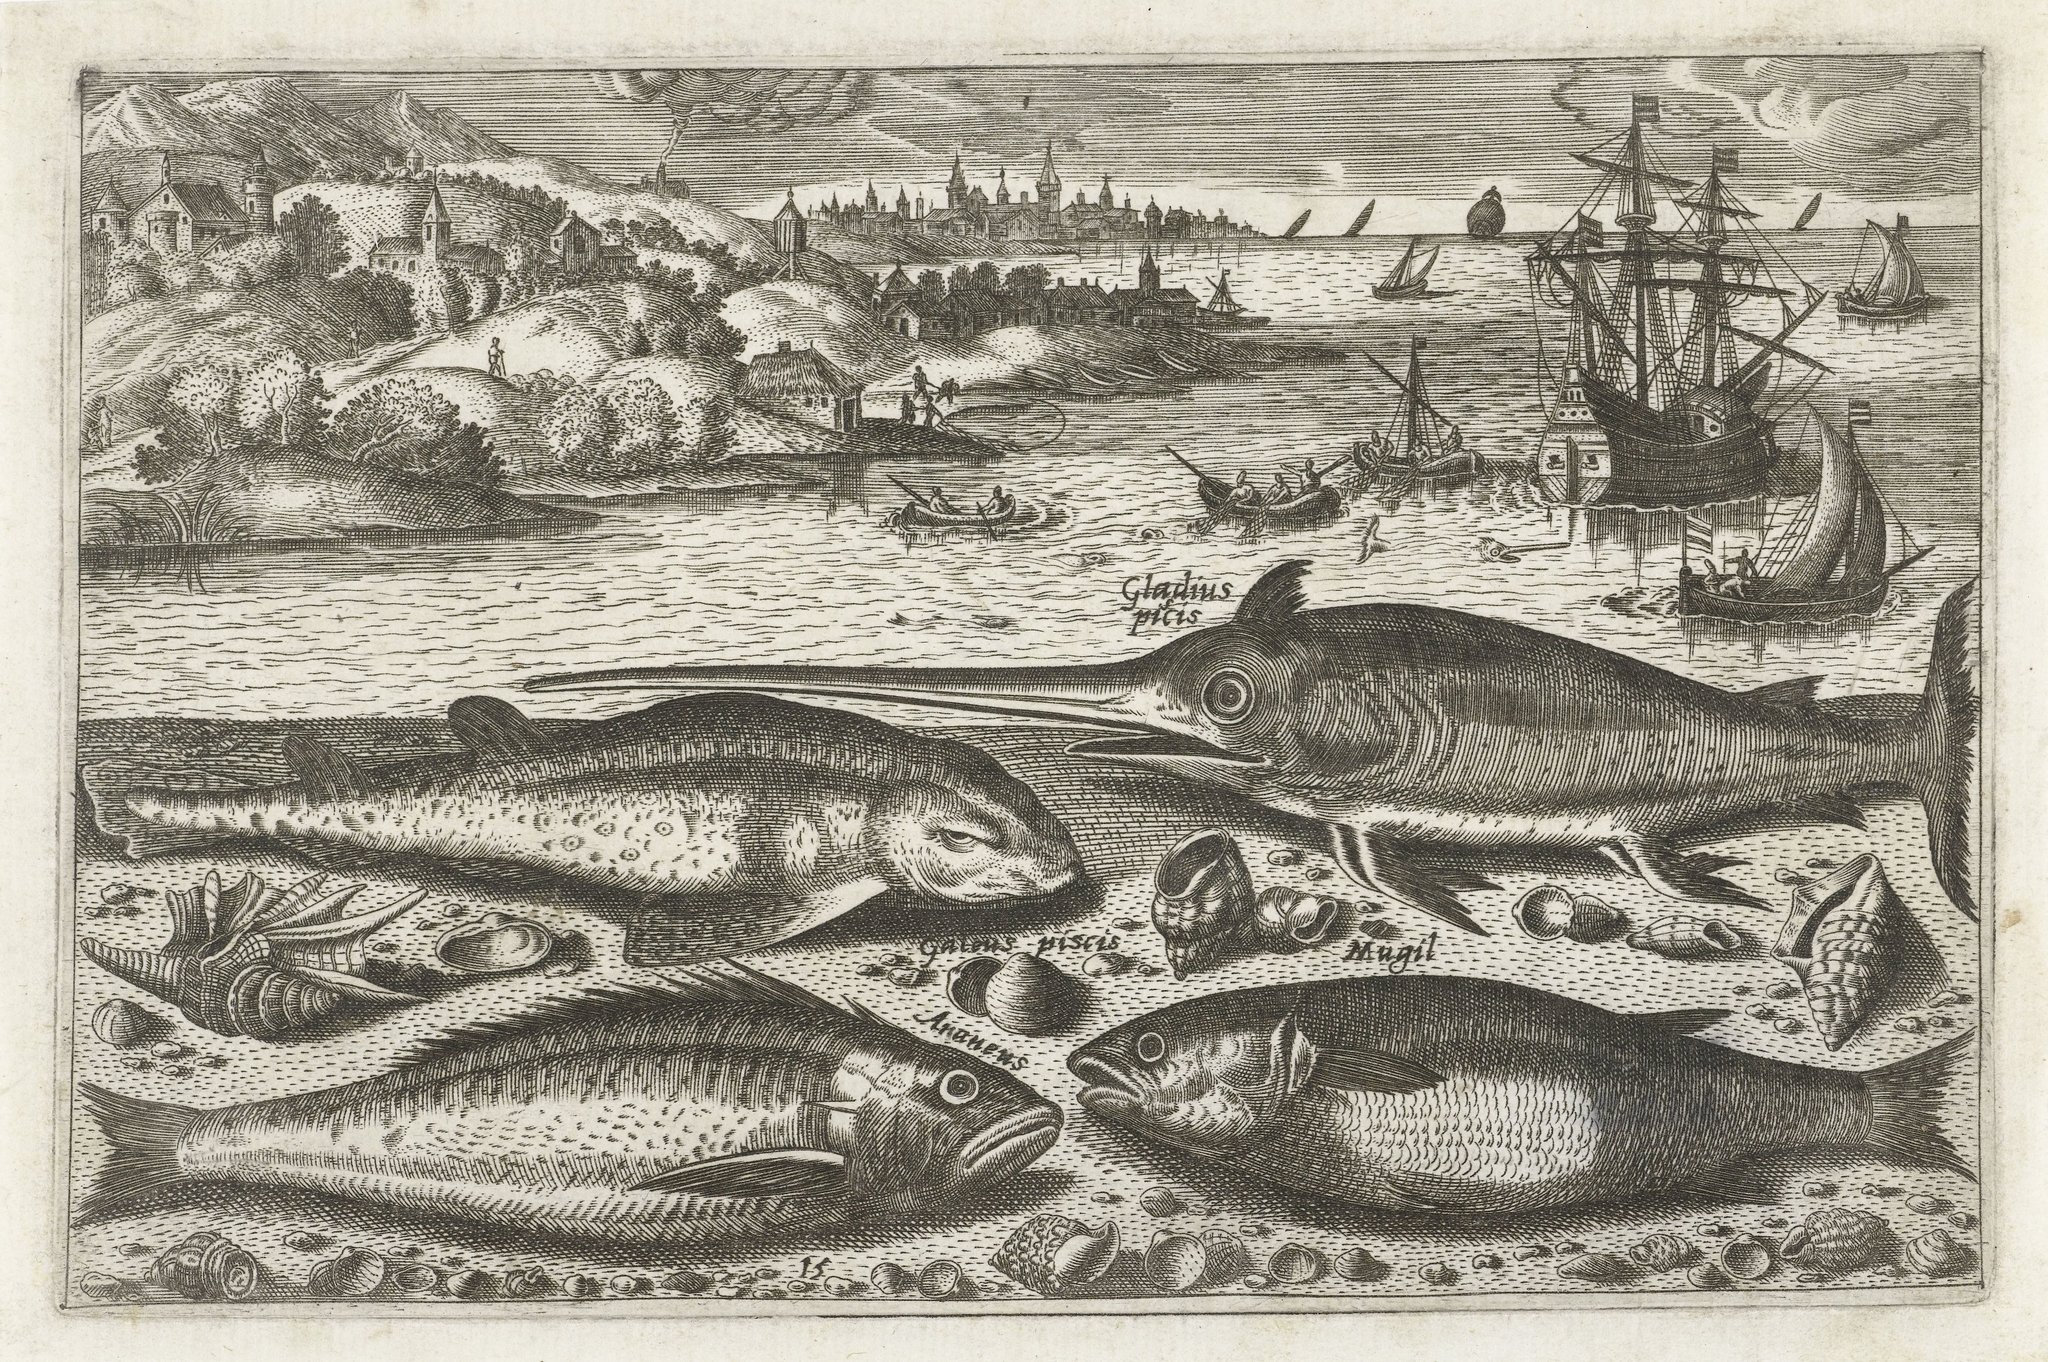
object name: print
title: Piscivm vivae icones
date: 1598-1620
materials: paper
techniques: engraving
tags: sea (seascape), bony fishes: mullet, bony fishes: sword-fish, cartilaginous fishes: dogfish, bony fishes: weever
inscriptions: collector's mark: Lugt 2166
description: Een zwaardvis, een harder, een kathaai en een pieterman liggen samen met wat schelpen aangespoeld op het strand. Op de achtergrond de zee en wat schepen. De prent maakt deel uit van een serie met vissen als onderwerp.